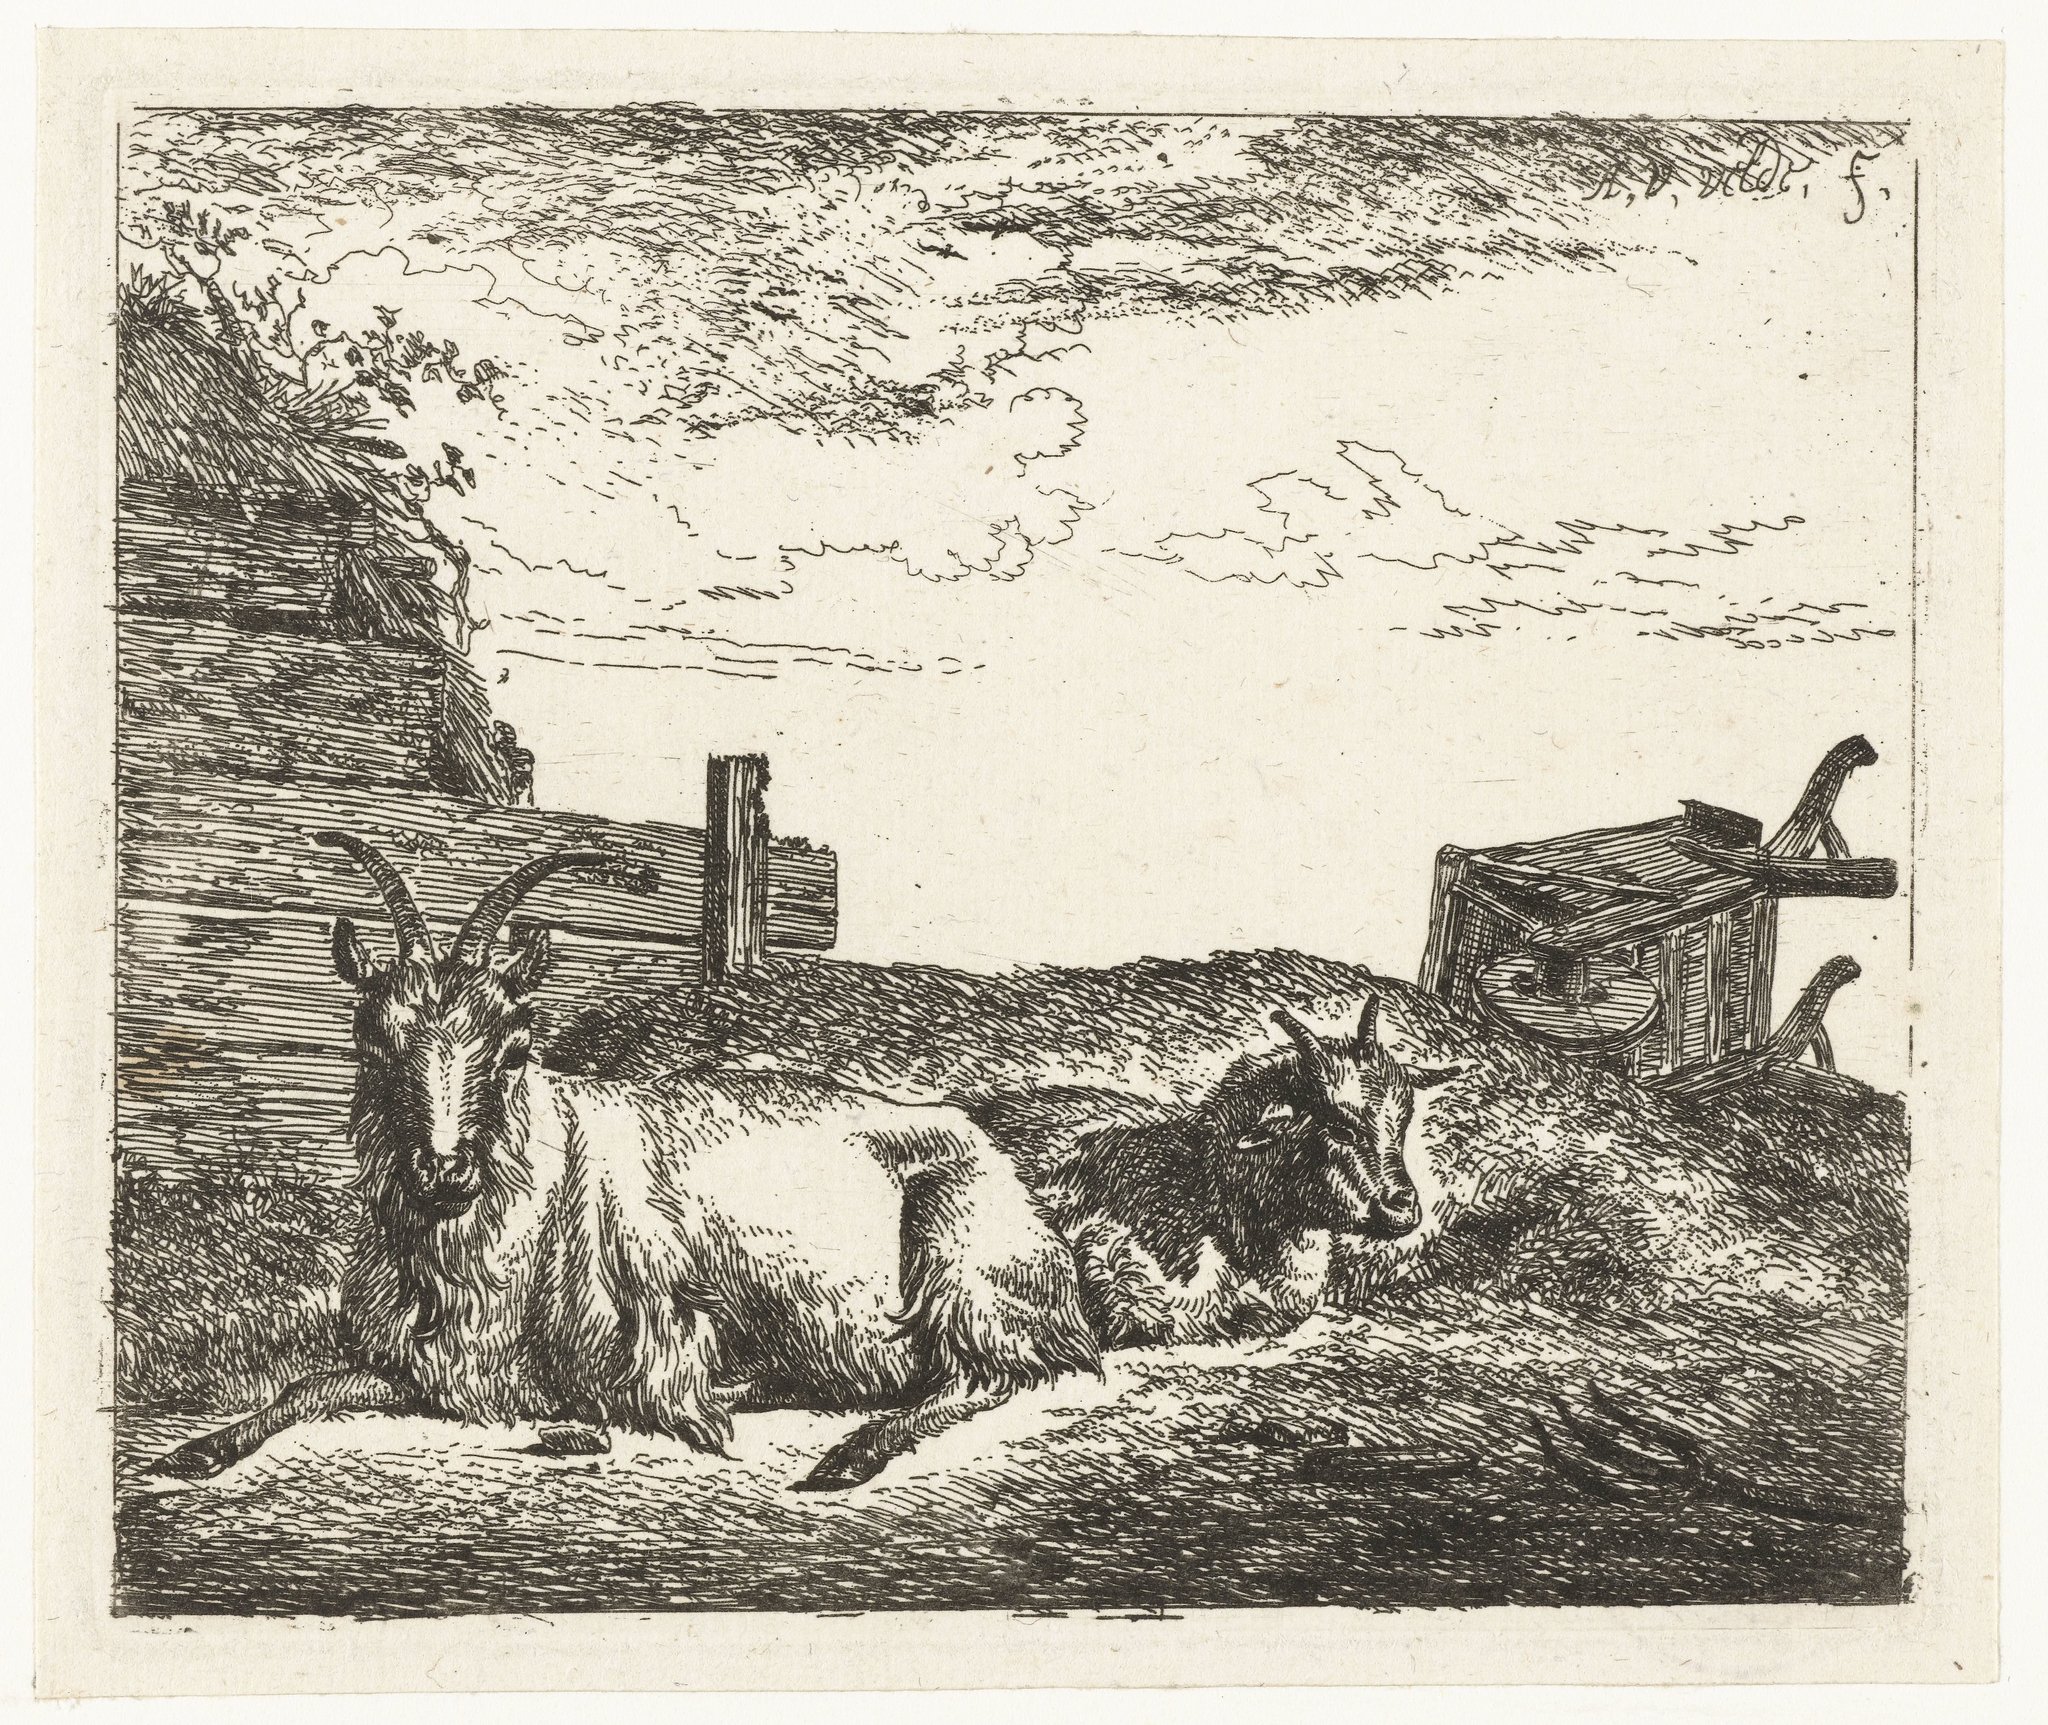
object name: print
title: Verschillende dieren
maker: adriaen van de velde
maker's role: draughtsman, painter, print maker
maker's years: 1636-1672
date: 1657-1659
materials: paper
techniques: etching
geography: amsterdam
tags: she-goat, nanny-goat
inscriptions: collector's mark: Lugt 240